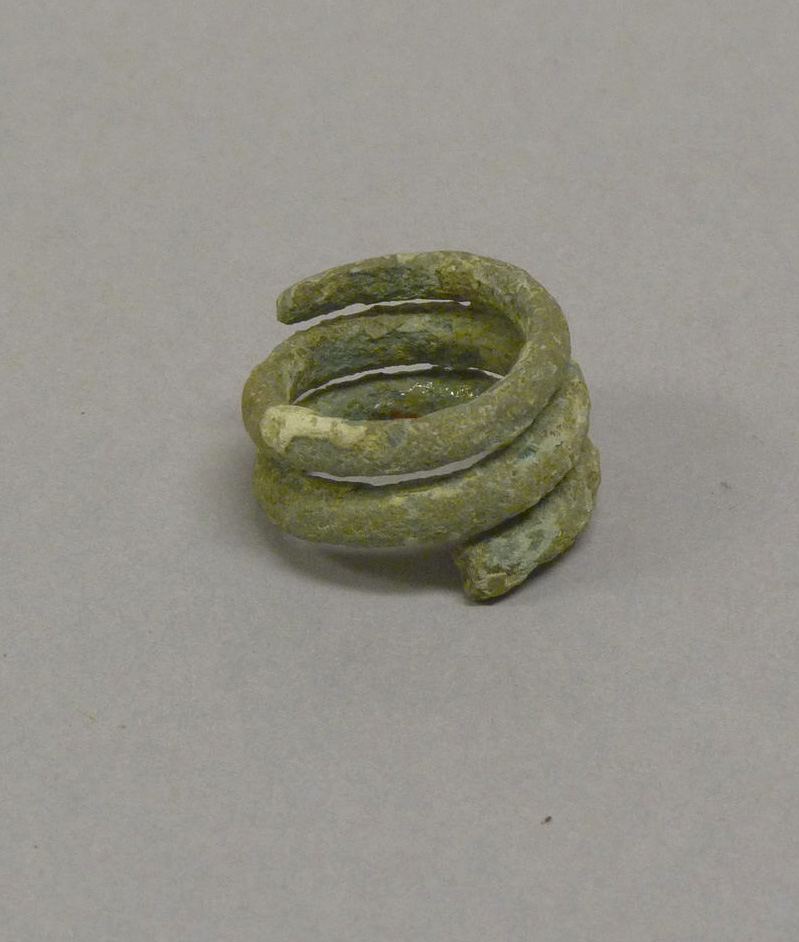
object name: ring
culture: thai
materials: bronze